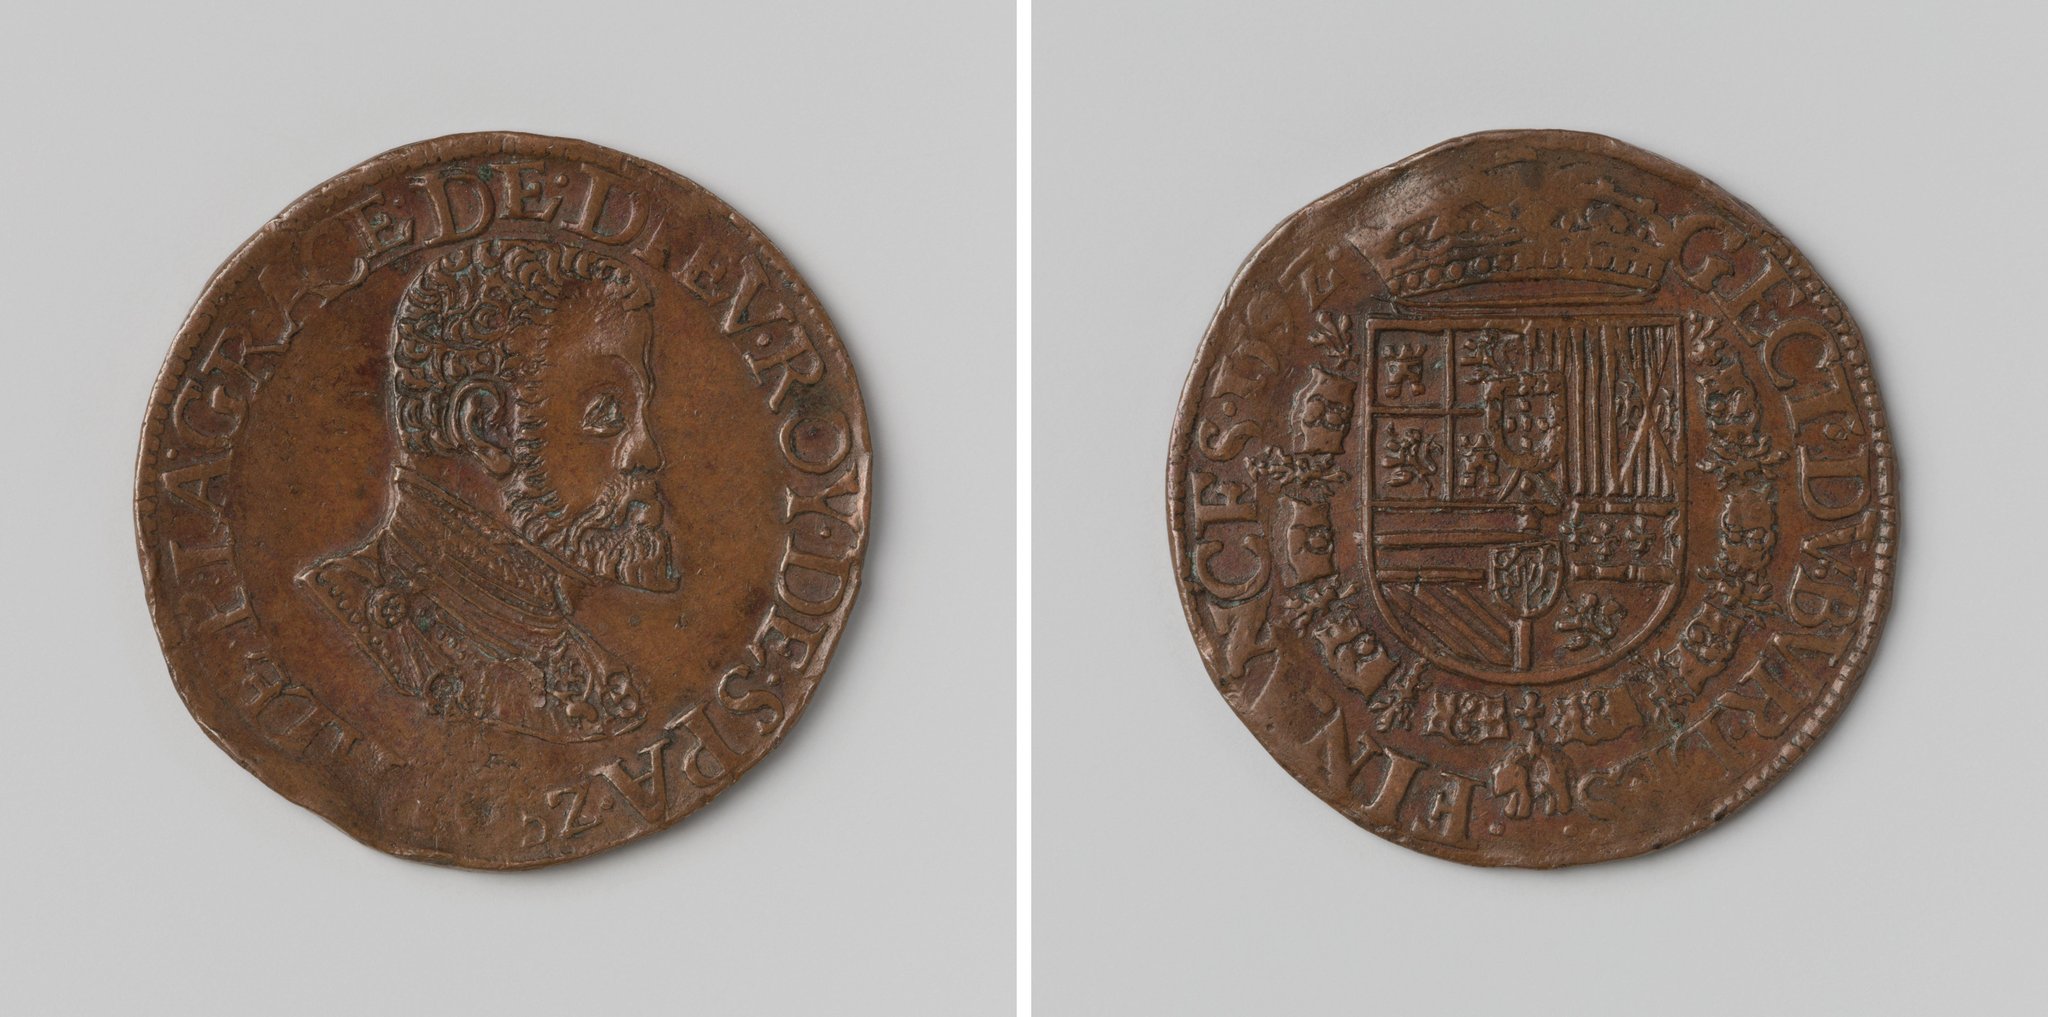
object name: jeton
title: Filips II, koning van Spanje, rekenpenning van de raad van Financiën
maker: Anonymous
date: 1592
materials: copper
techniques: striking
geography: antwerp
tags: philip ii of spain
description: Koperen penning. Voorzijde: borststuk man binnen omschrift. Keerzijde: gekroond wapenschild, omhangen met de orde van het Gulden Vlies binnen omschrift